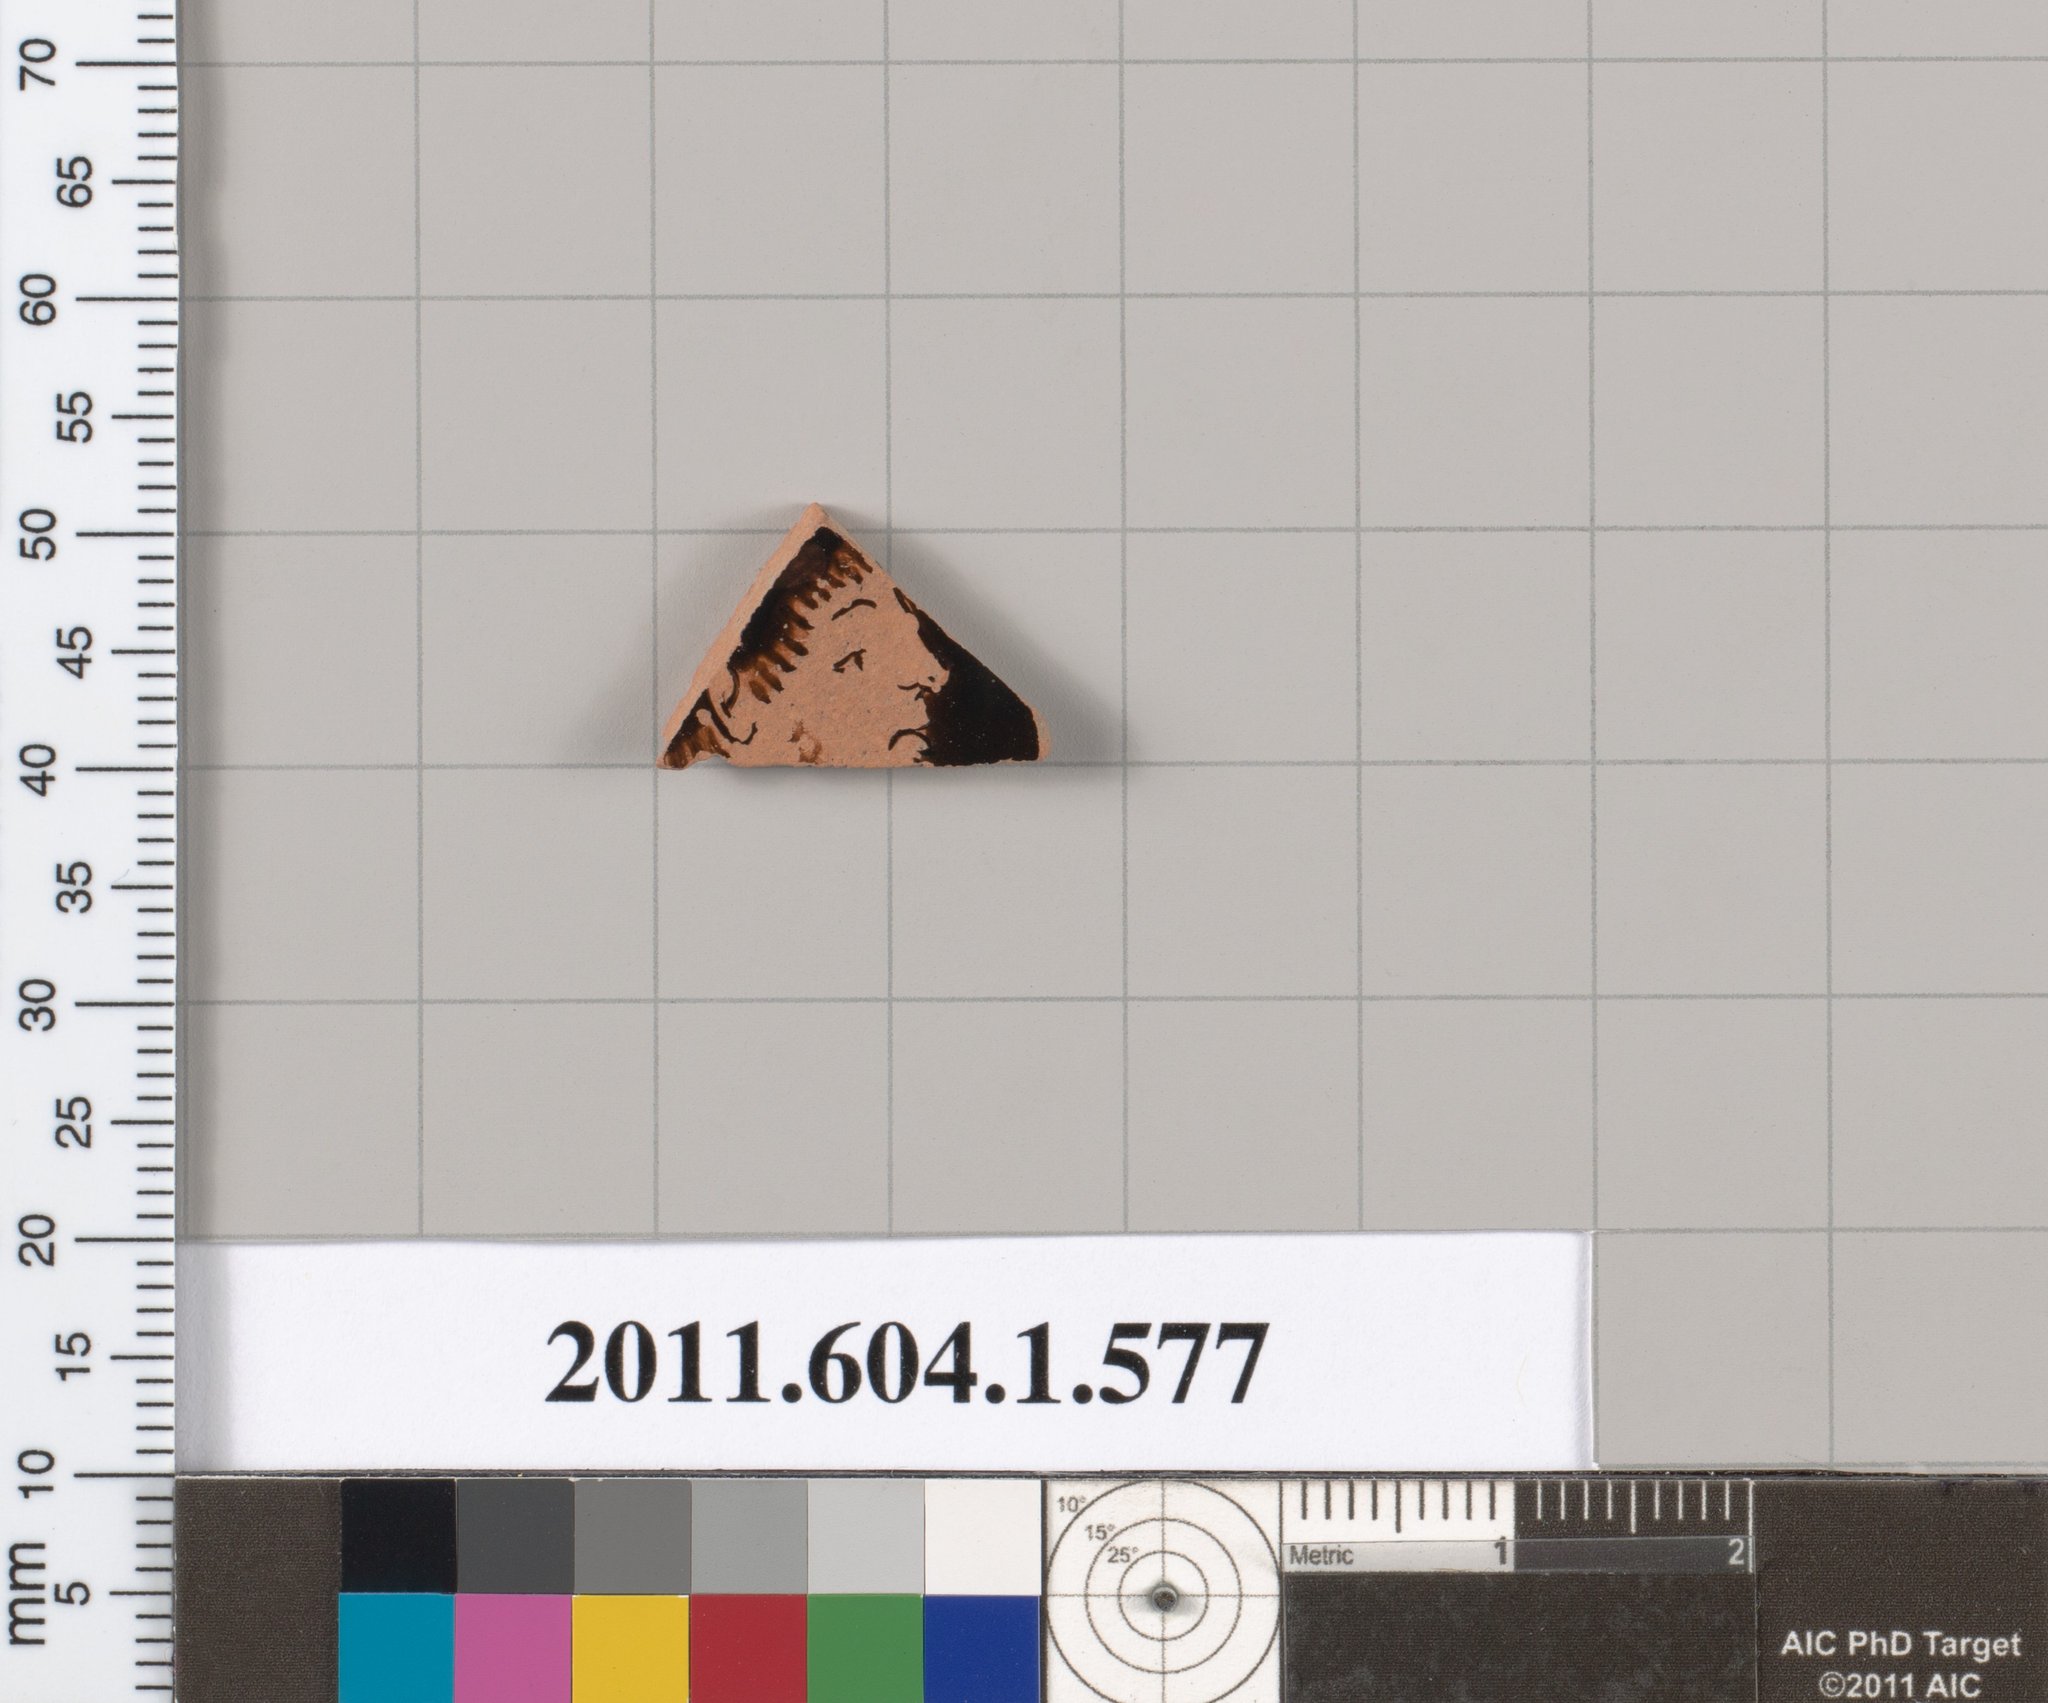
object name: kylix fragment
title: Terracotta fragment of a kylix (drinking cup)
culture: greek, attic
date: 475-451 BCE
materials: terracotta